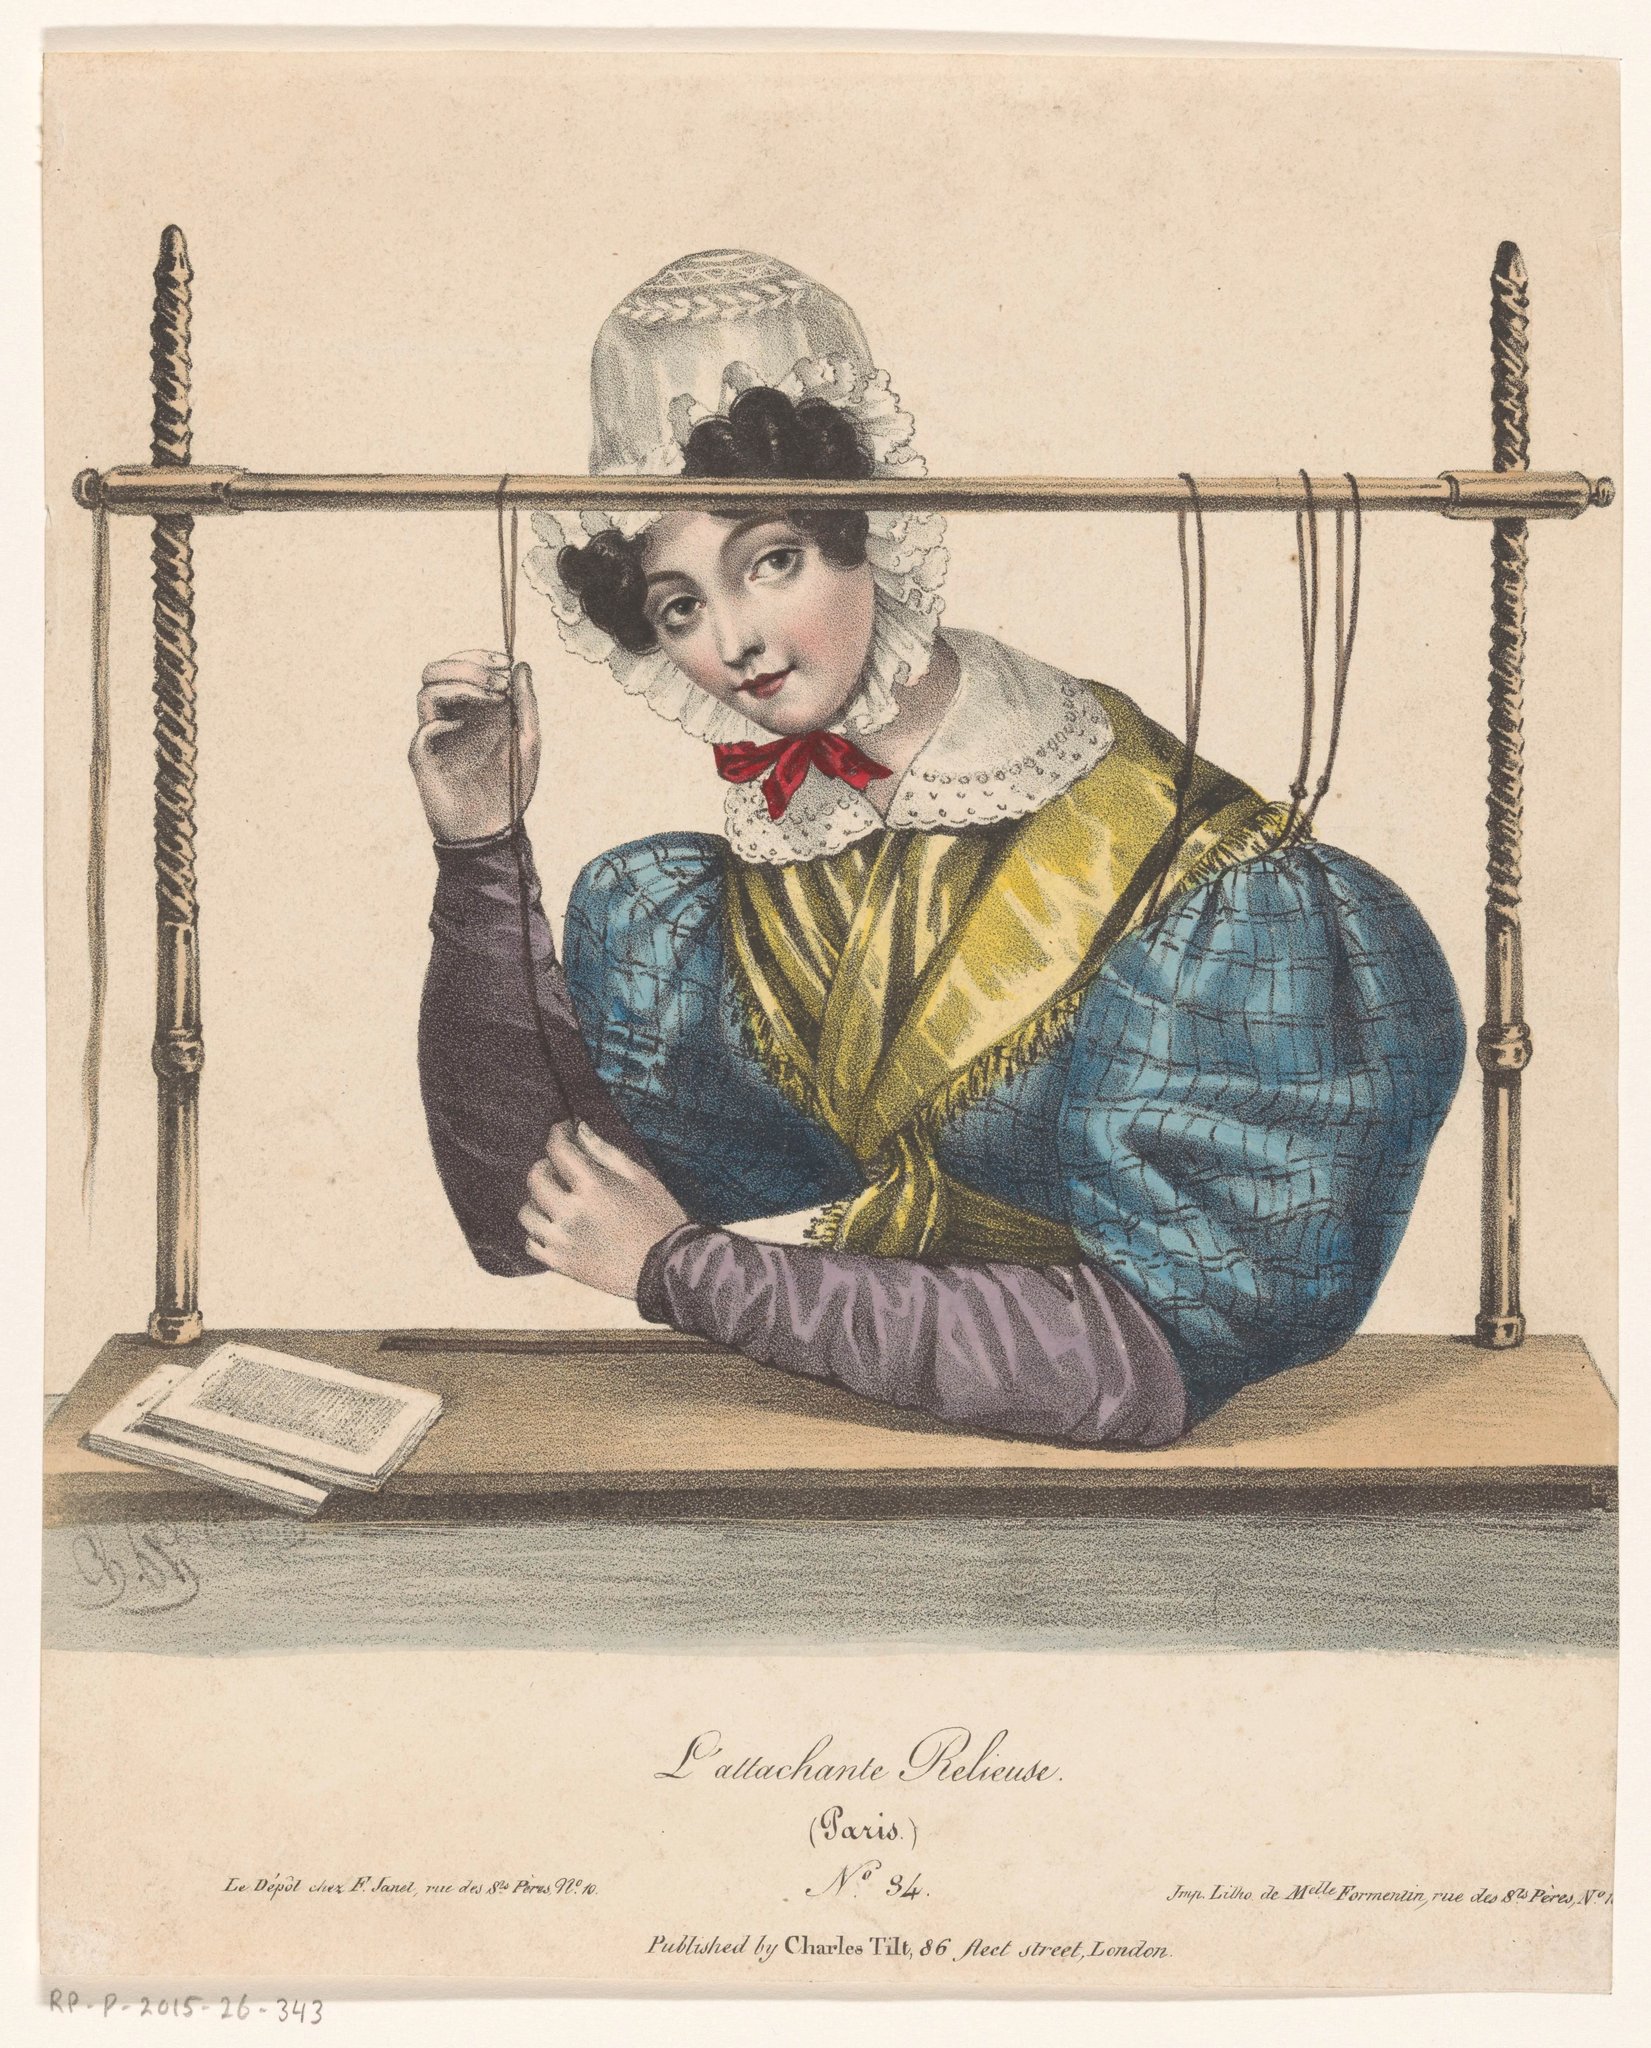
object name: print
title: L'attachante Relieuse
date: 1828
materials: paper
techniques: hand coloring, lithograph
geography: london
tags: bookbinding, handicrafts, craftsman at work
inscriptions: collector's mark: Lugt 2228, collector's mark: Lugt 4779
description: Jonge vrouw achter een naaibank met enkele losse katernen.